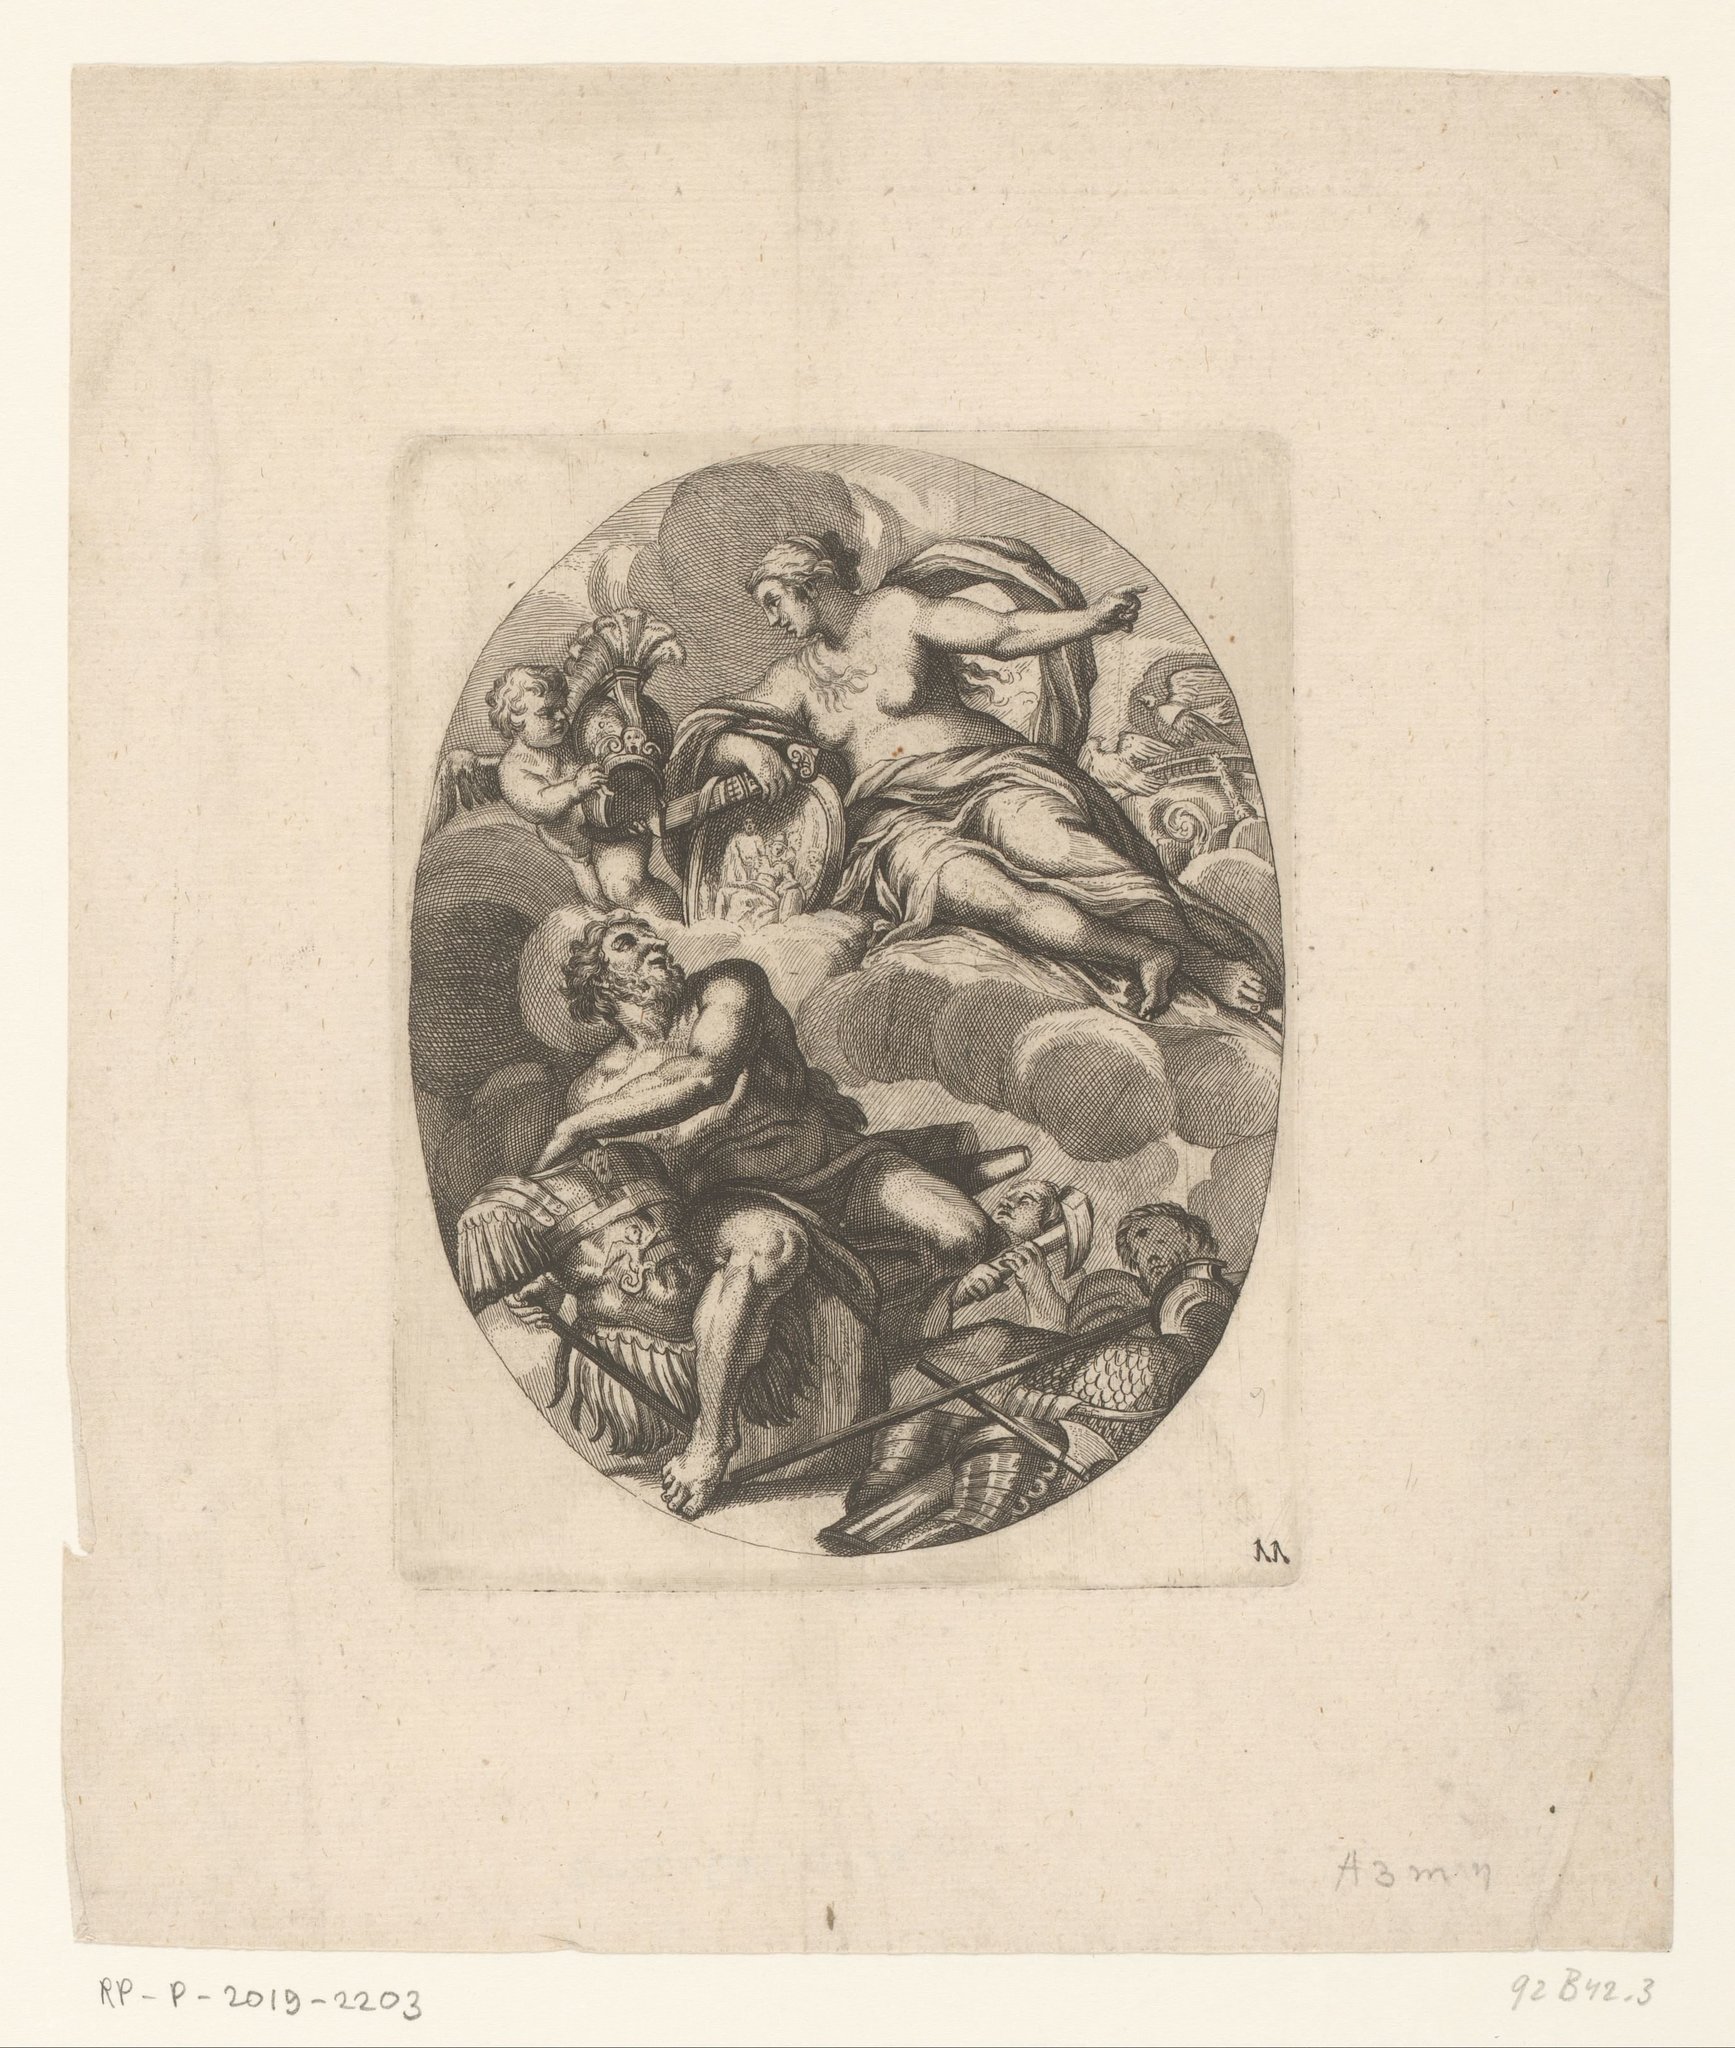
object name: print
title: Mars en Venus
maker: Anonymous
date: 1650-1750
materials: paper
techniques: engraving, etching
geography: france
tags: mars and venus as lovers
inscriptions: collector's mark: Lugt 2228